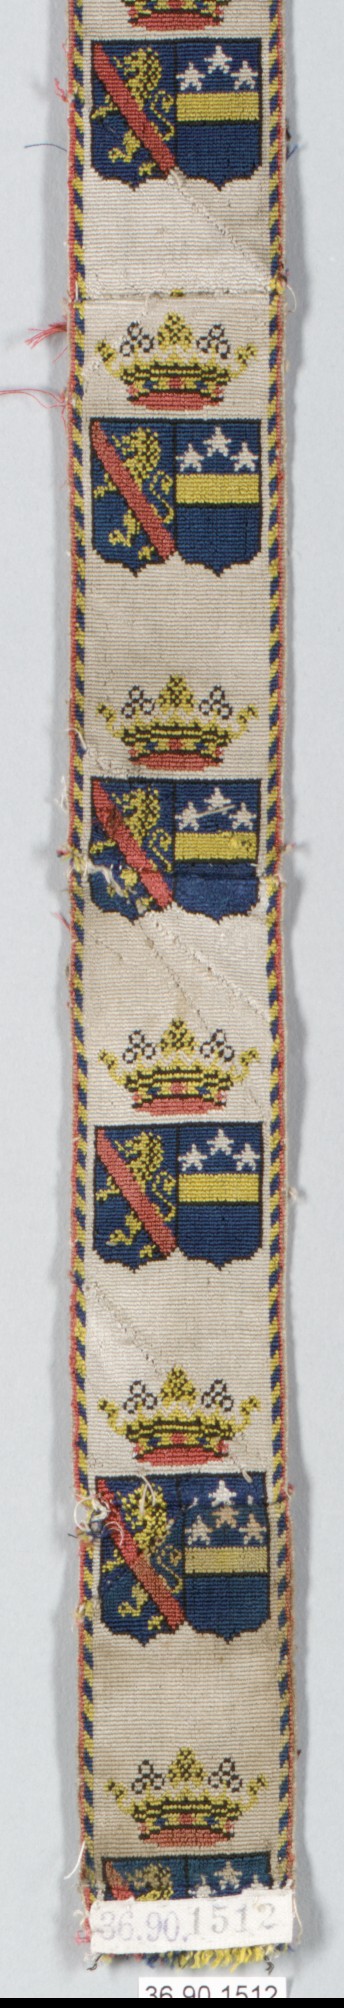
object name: piece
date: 1701-1900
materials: silk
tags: coat of arms